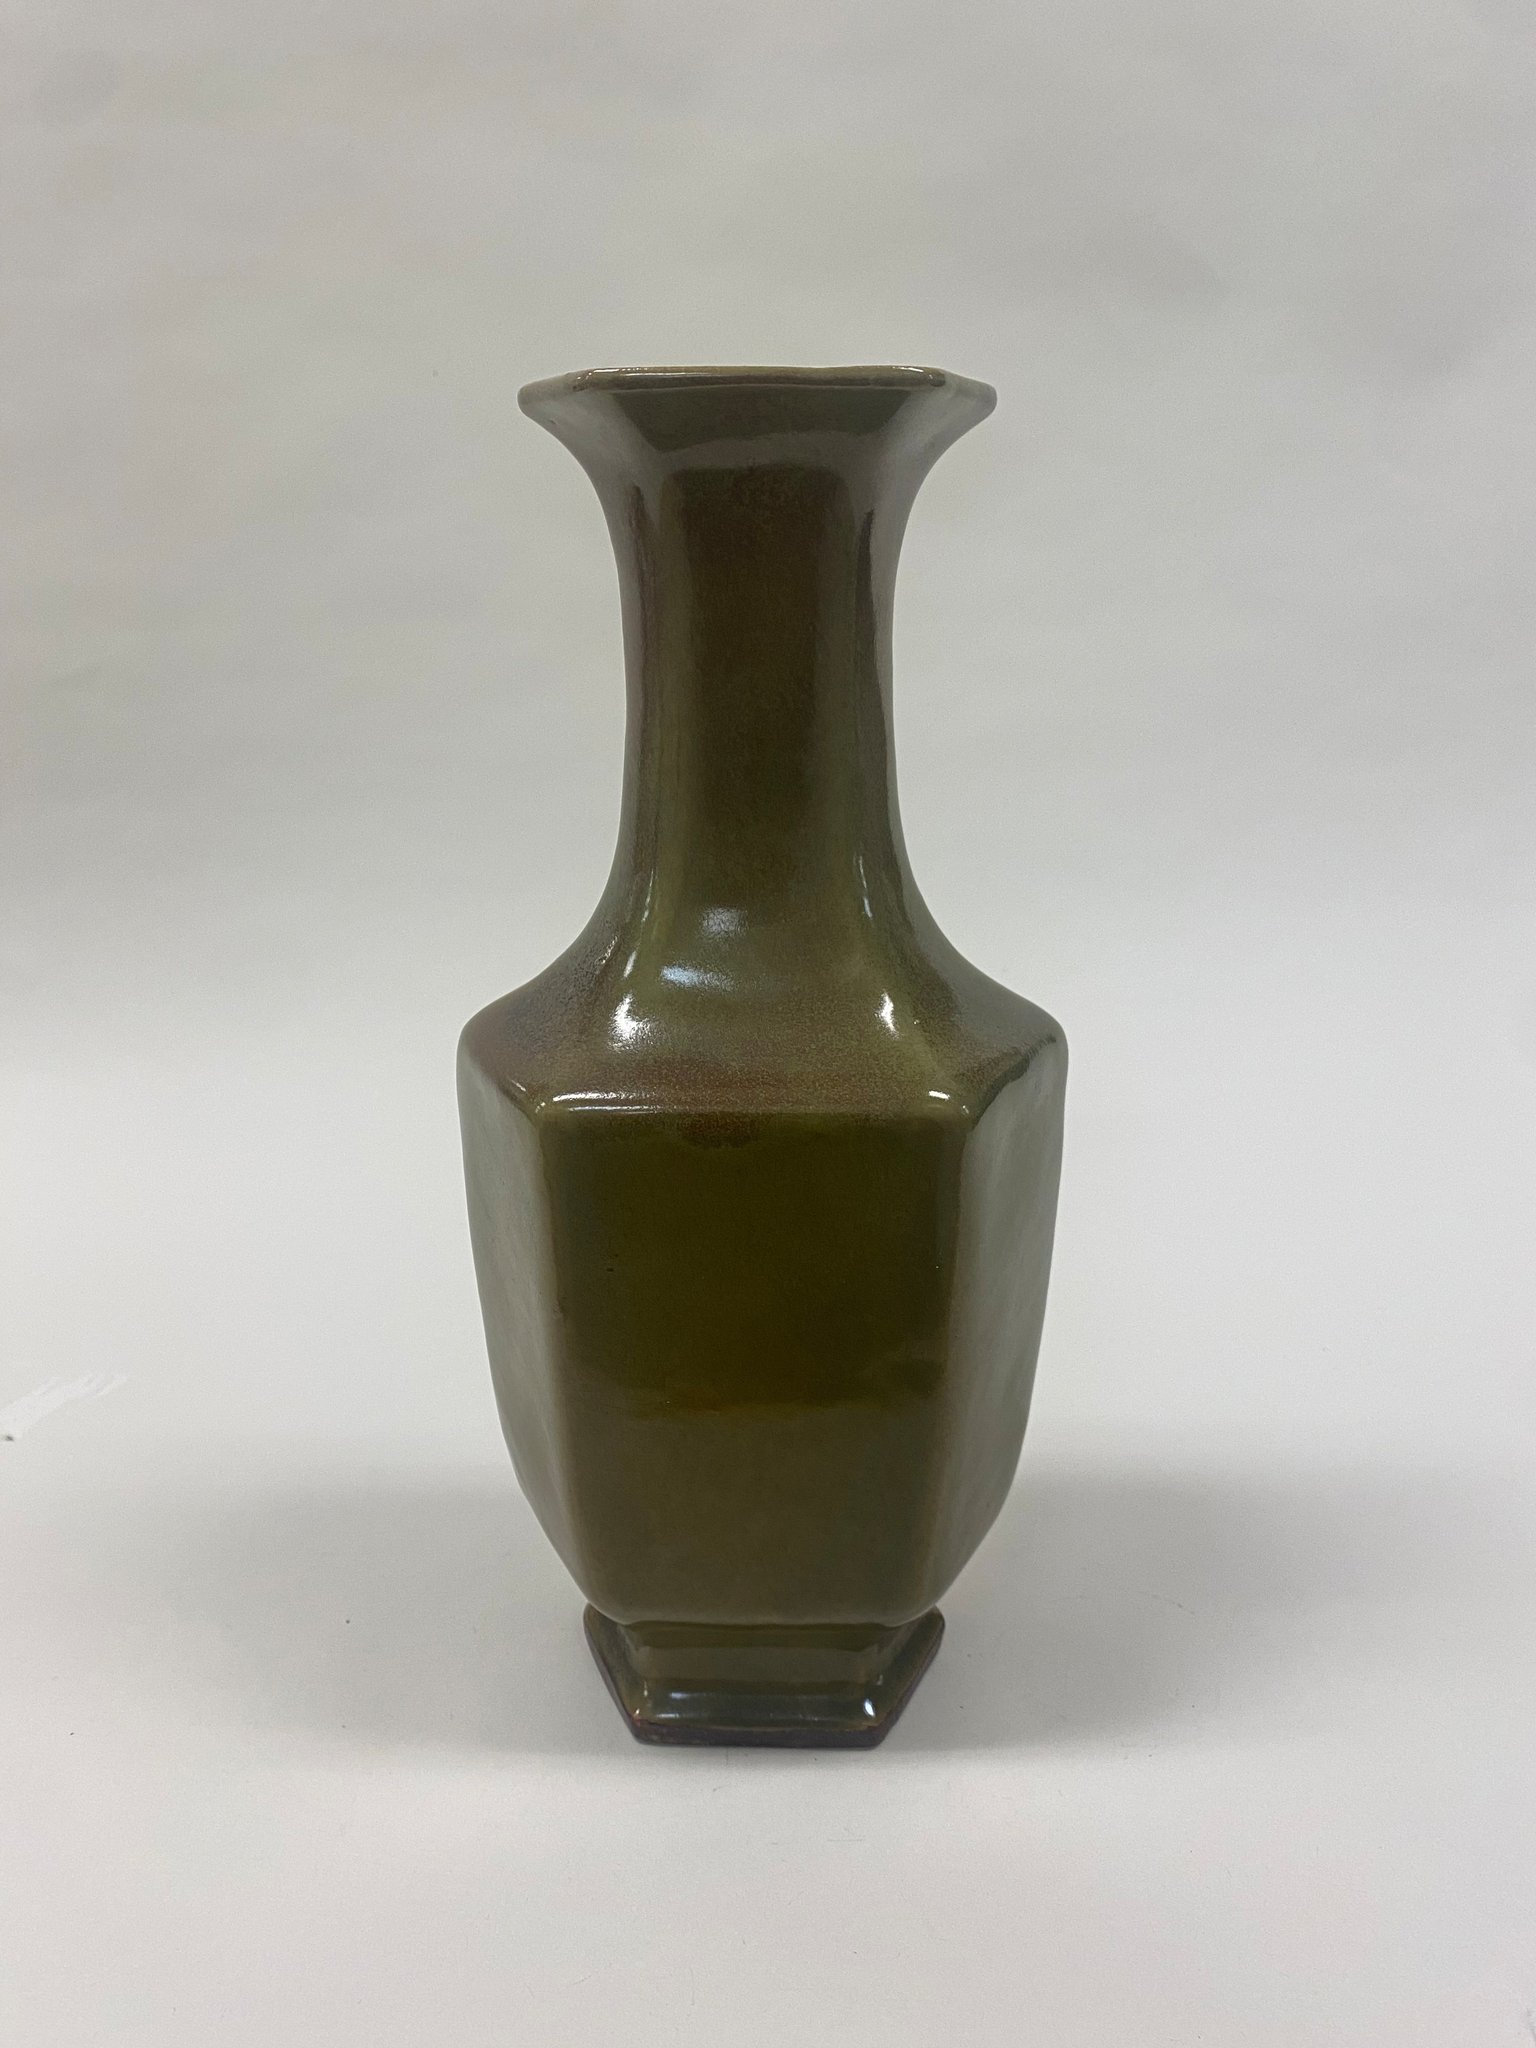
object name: vase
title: Hexagonal vase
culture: chinese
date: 1767-1833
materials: glaze, porcelain